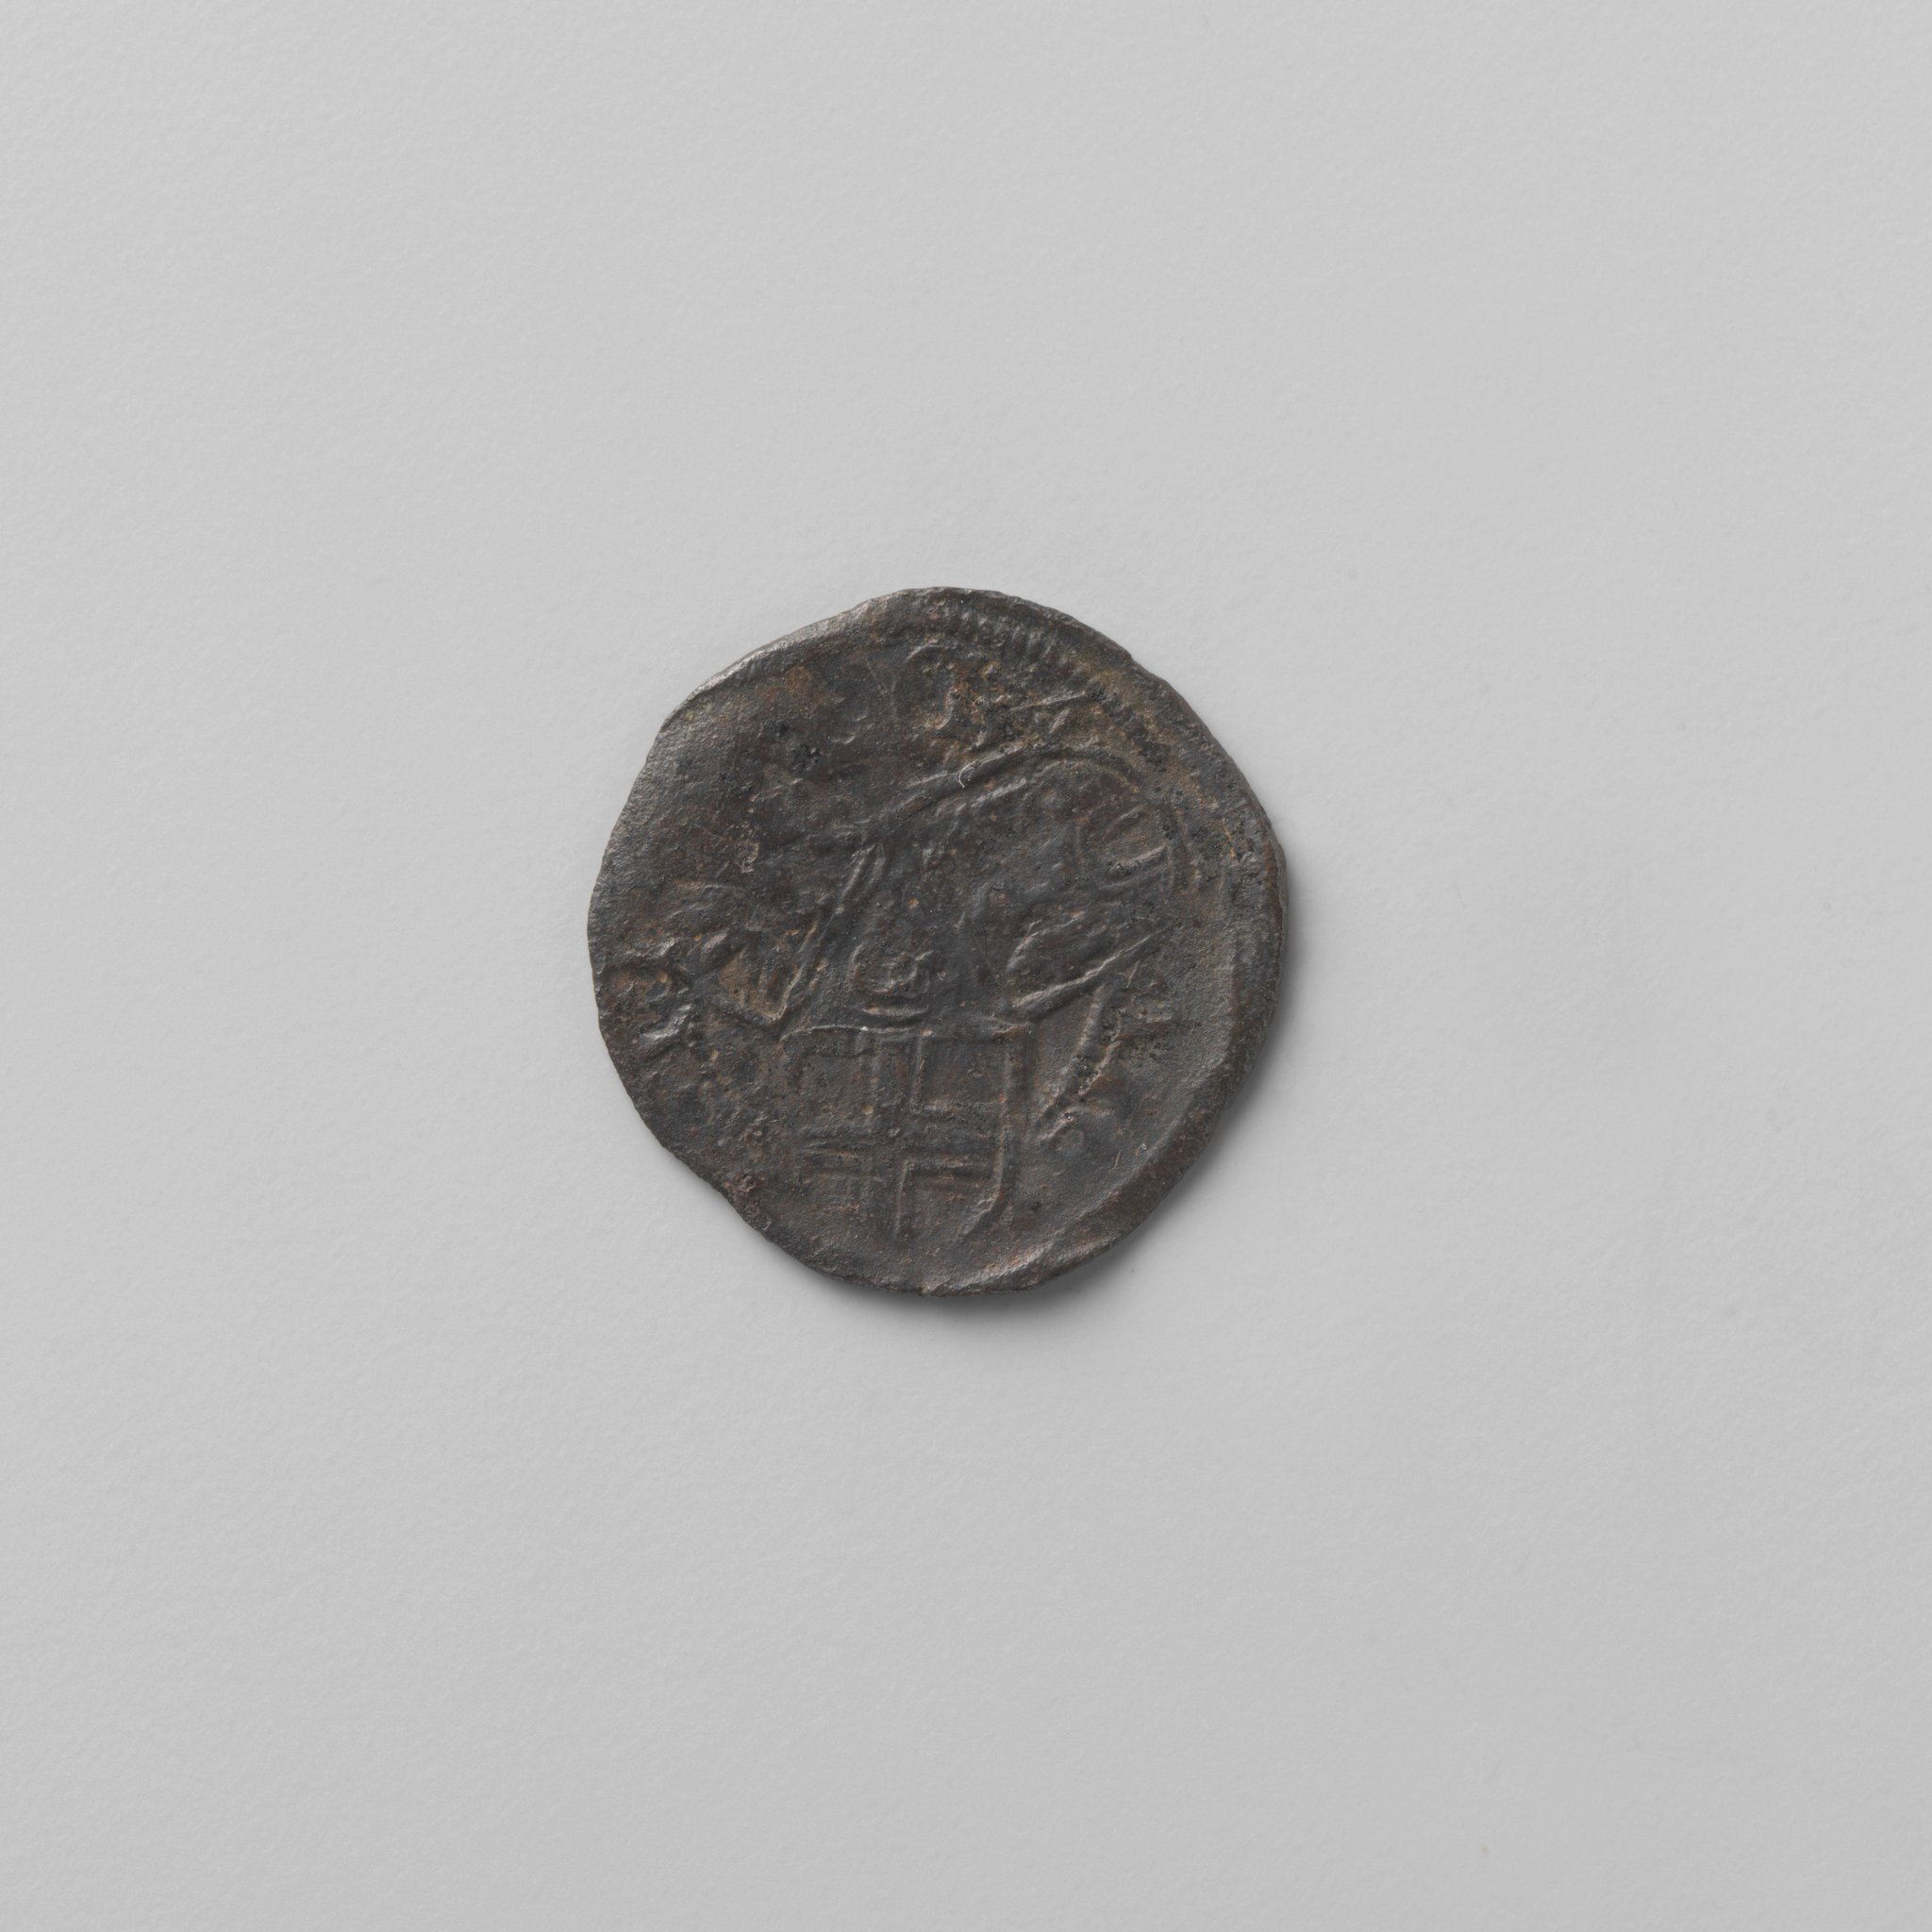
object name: coin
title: Halve plak van de Drie Steden, 1534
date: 1534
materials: silver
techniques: striking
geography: deventer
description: Zilveren munt. Voorzijde: versierd lang kruis. In het centrum een ster. Keerzijde: wapenschilden van de Drie Steden, in het centrum letter D. Jaartal in omschrift.